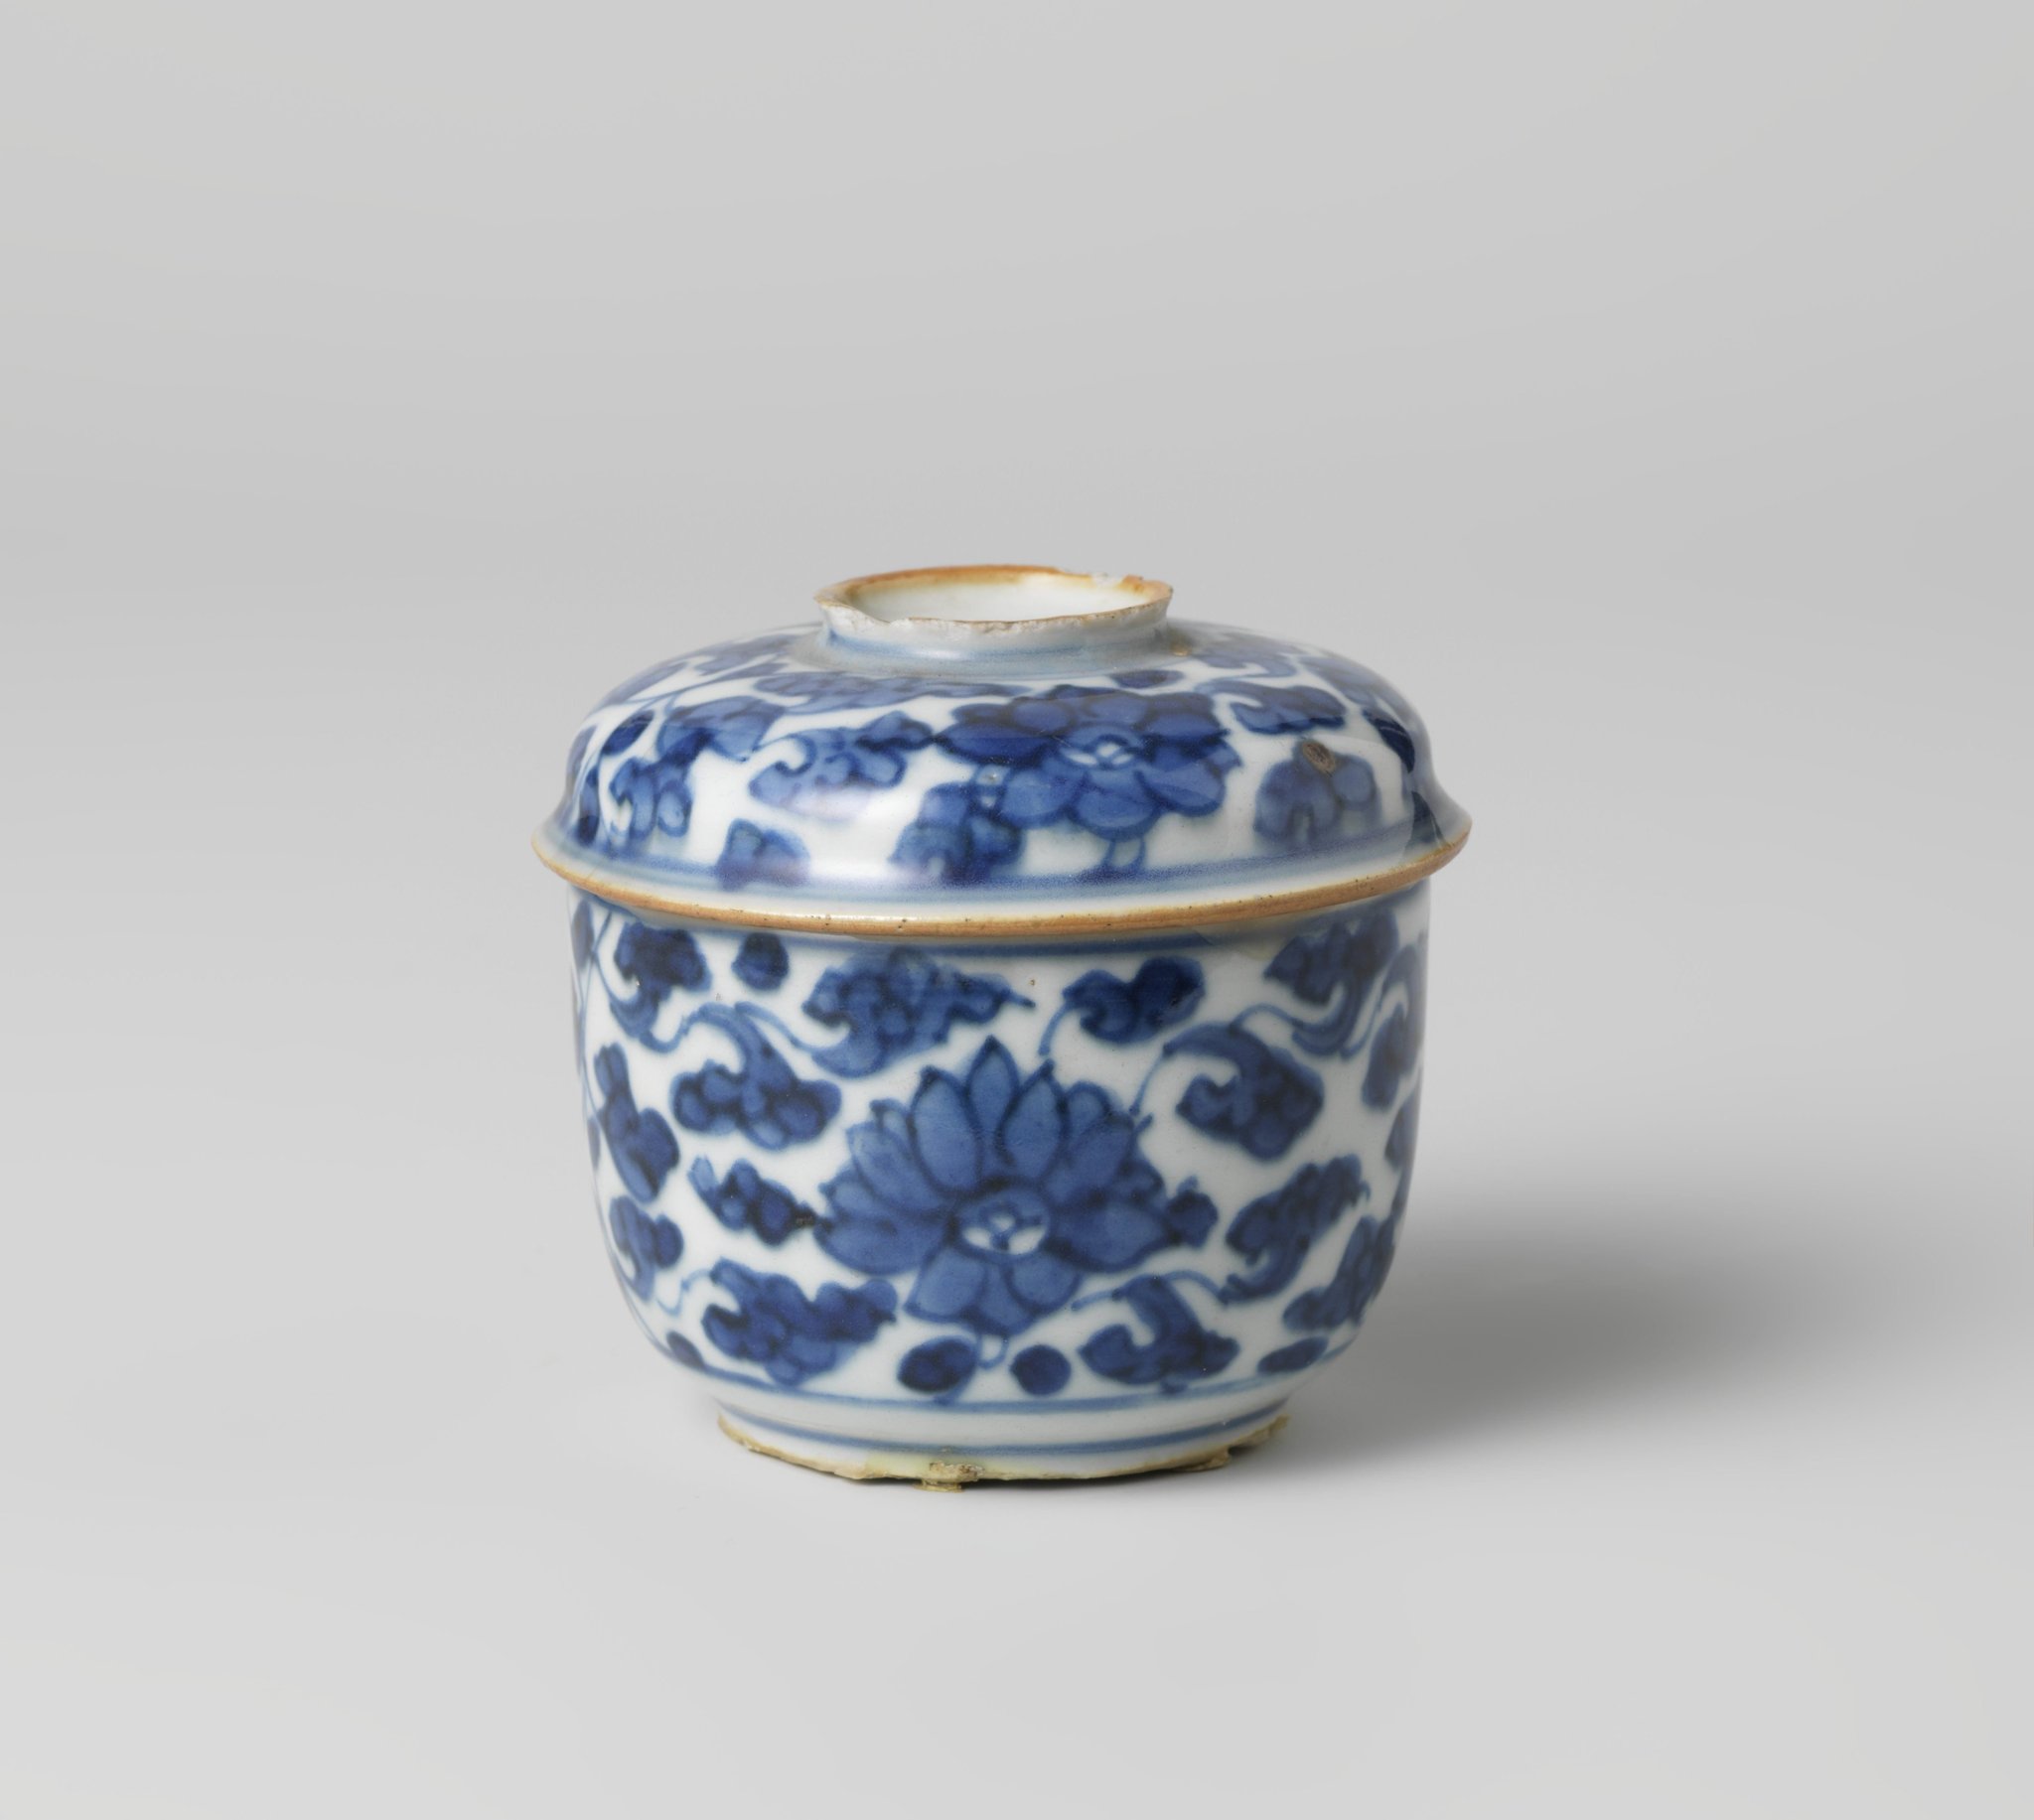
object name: covered jar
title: Covered jar with continuous lotus scrolls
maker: Anonymous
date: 1740-1760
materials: cobalt, glaze, paint, porcelain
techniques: firing, turning, vitrification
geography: china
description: Dekselpot van porselein, beschilderd in onderglazuur blauw. Op de wand een band met doorlopende lotusranken. De deksel met dezelfde decoratie. Deksel is verlijmd. Enkele chips en een barst in de dekselpot. Blauw-wit.